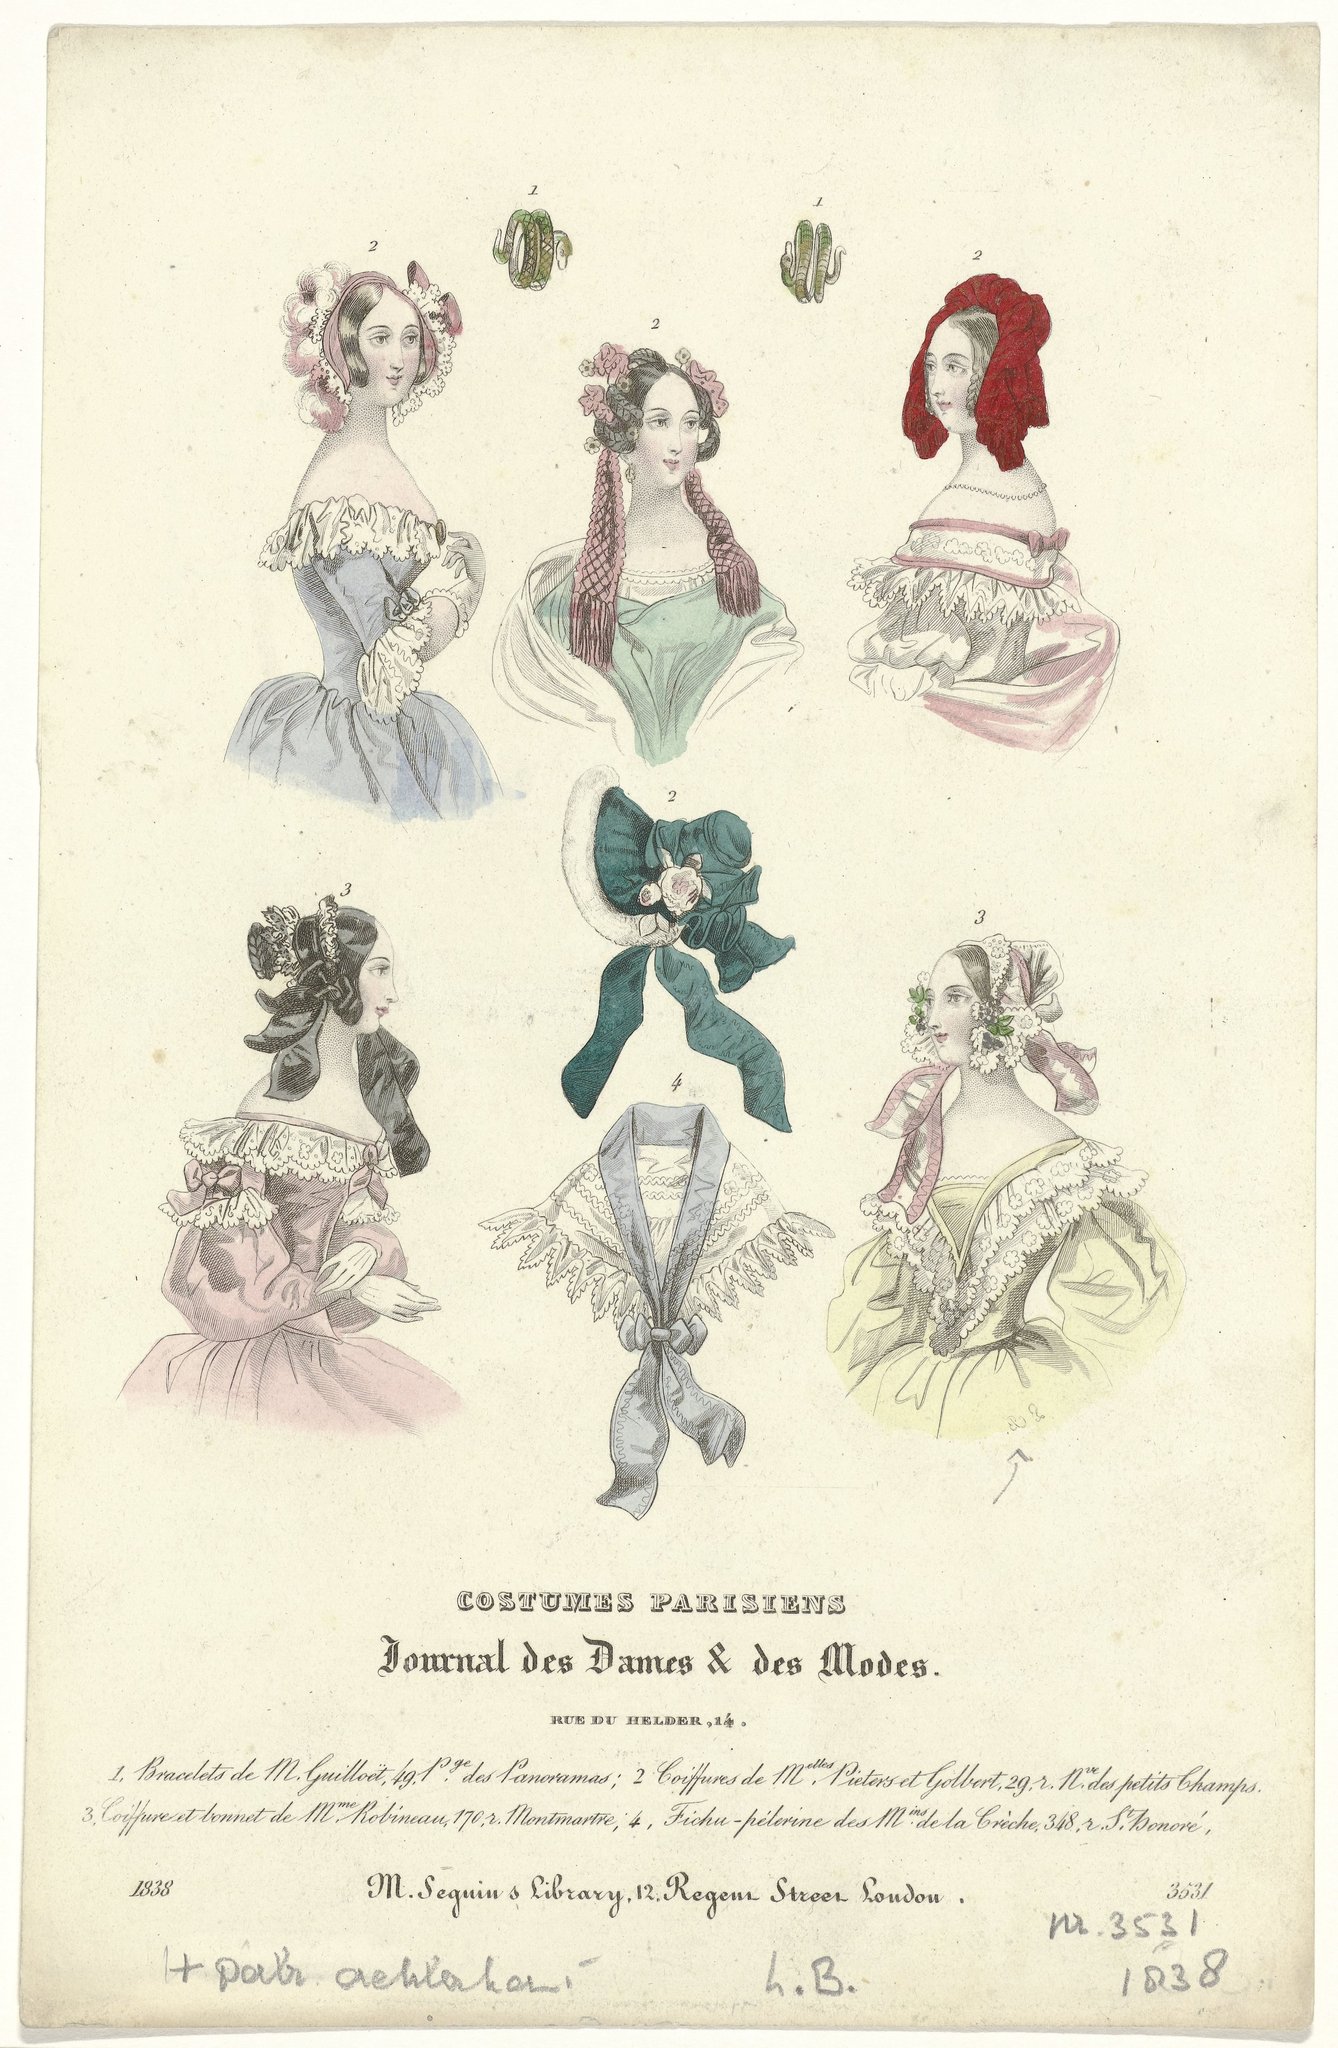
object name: fashion print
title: Journal des Dames et des Modes, Costumes Parisiens, 1838, (3531): 1, Bracelets de M.Guilloët (...)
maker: Anonymous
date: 1838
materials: paper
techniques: engraving, hand coloring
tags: clothing for the upper part of the body (+ women's clothes), styles of hairdress - aa - ~ women, head-gear: cap (+ women's clothes), fashion plates, piece of clothing covering the breast or décolleté (fichu) (+ women's clothes), bracelet, wristlet (+ women's clothes)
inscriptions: address: ‘Rue du Helder, 14. / M. Seguin s Library, 12. Regent Street London.’, title: ‘Costumes Parisiens / Journal des Dames & des Modes.’, caption: ‘1, Bracelets de M. Guilloët, 49. P.ge des Panoramas; 2 Coiffures de M.elles Pieters et Golbert, 29,r. N.ve des petits Champs. 3, Coiffure et bonnet de M.me Robineau, 170,r. Montmartre; 4, Fichu-pélerine des M.ins de la Crèche, 348,r. St. Honoré’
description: Vijf vrouwenbustes en diverse accessoires, genummerd één tot en met vier. 1. Twee armbanden van Guilloët. 2. 'Coiffures' van Pieters en een luifelhoed. 3, Twee vrouwen met een 'coiffure' en muts van Robineau. 4, 'Fichu-pelerine' uit de winkel van Crèche. De prent maakt deel uit van het modetijdschrift Journal des Dames et des Modes, Parijs, 1797-1839.